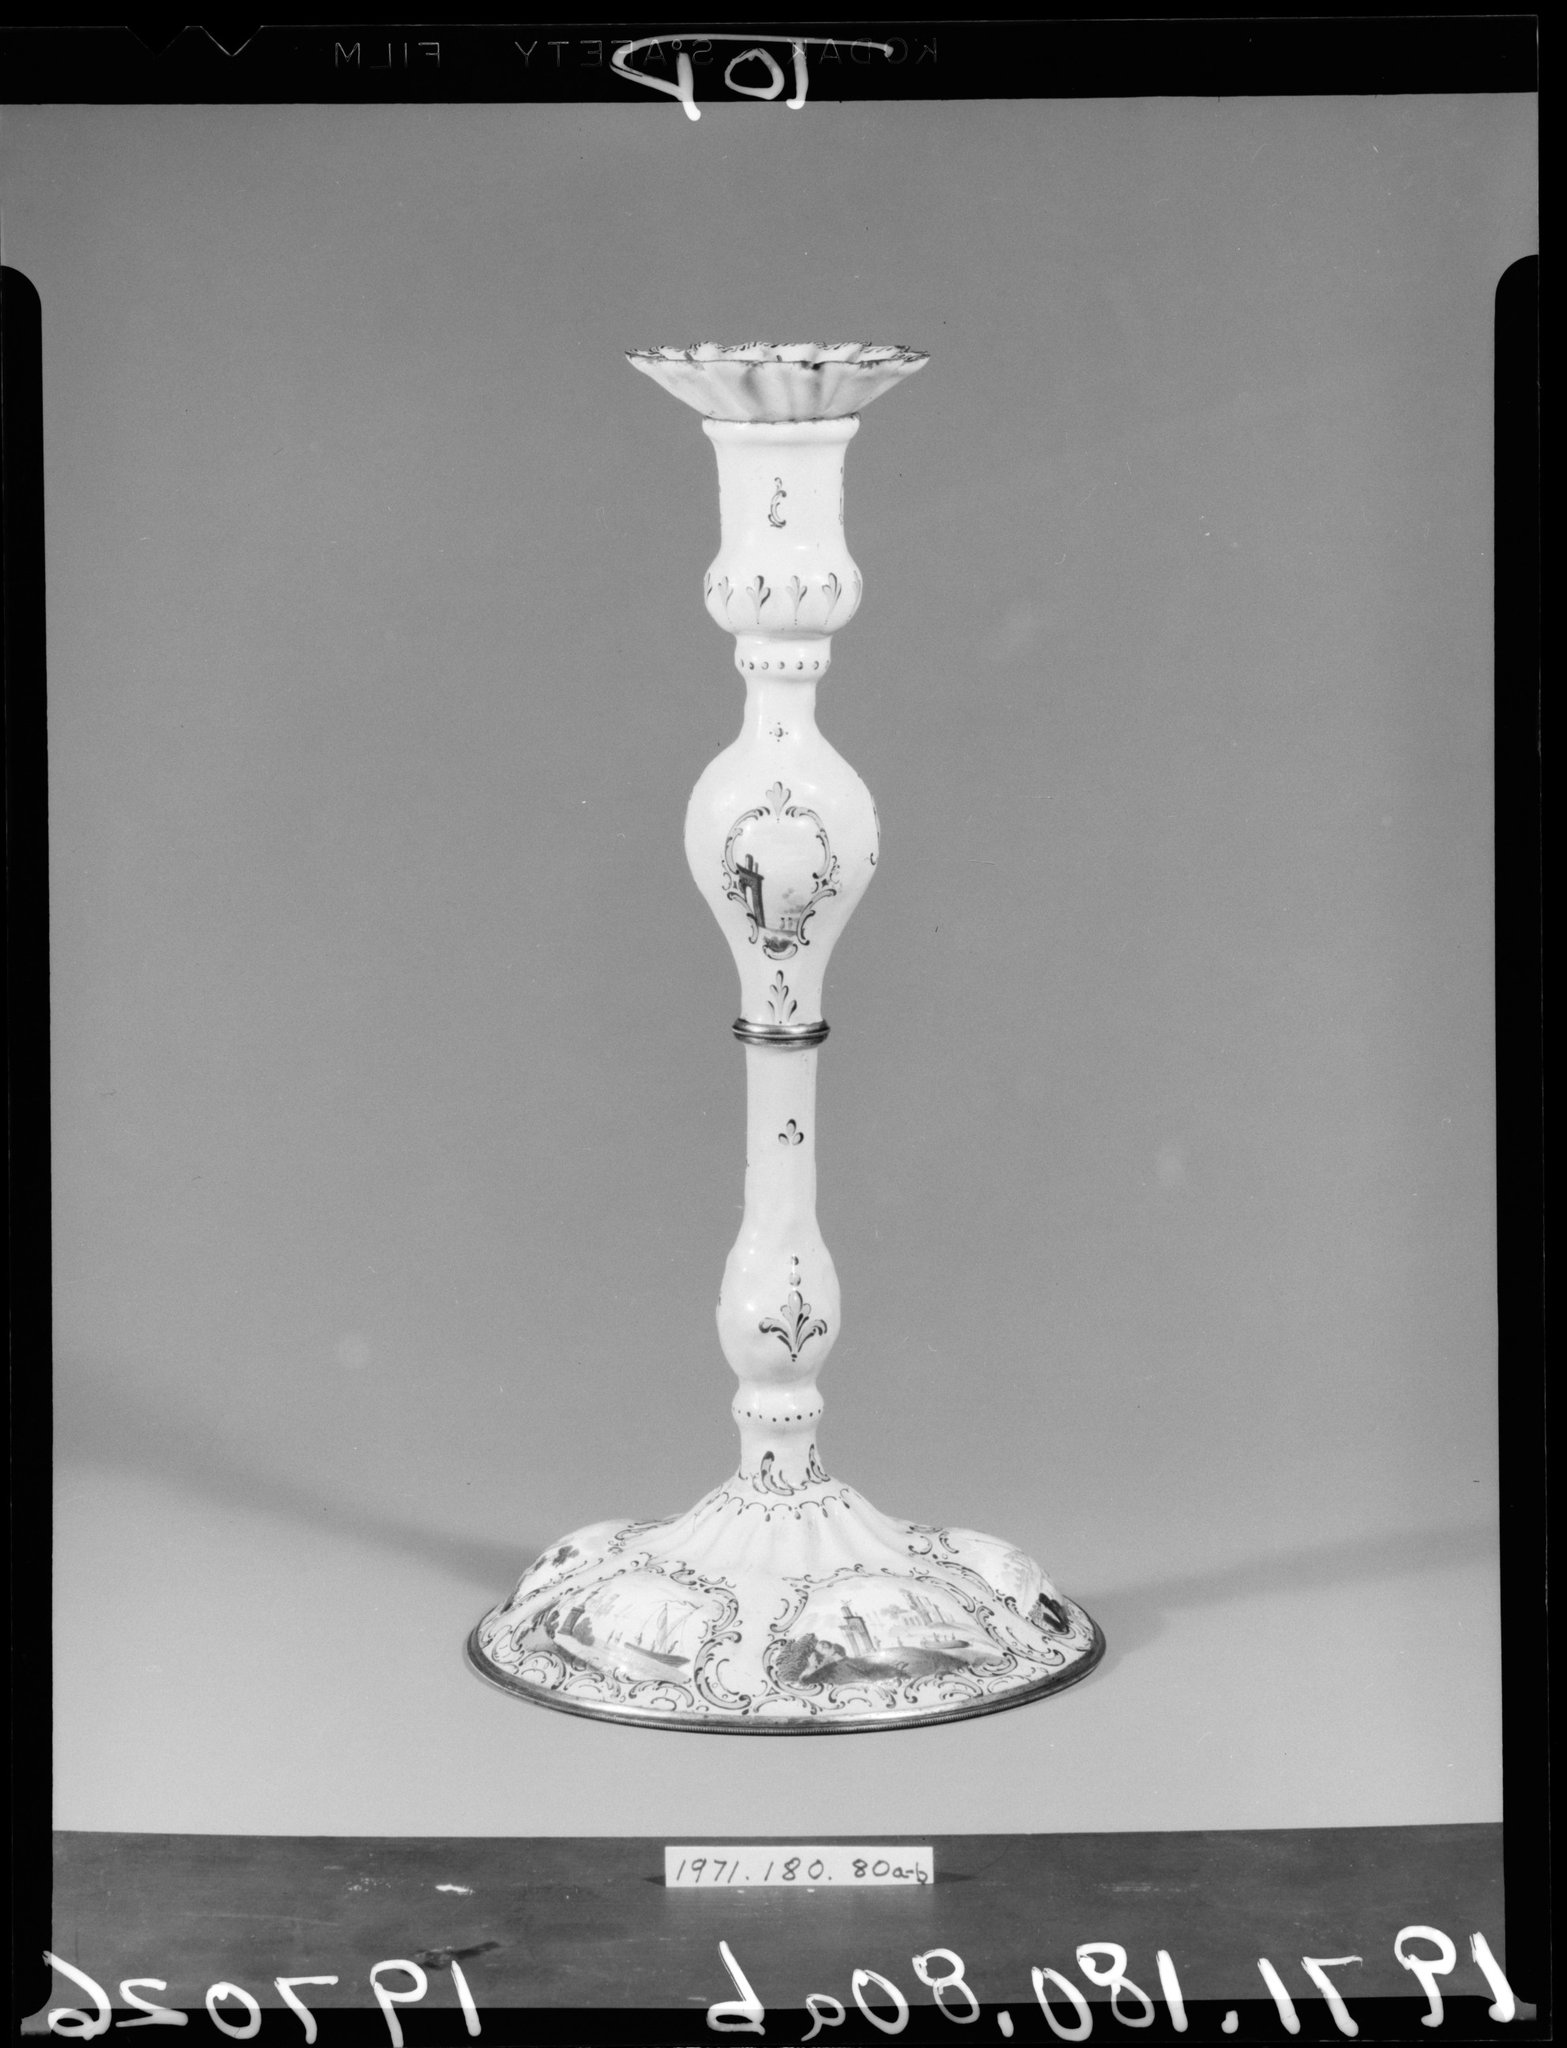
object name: candlestick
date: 1700-1800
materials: copper, enamel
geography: england